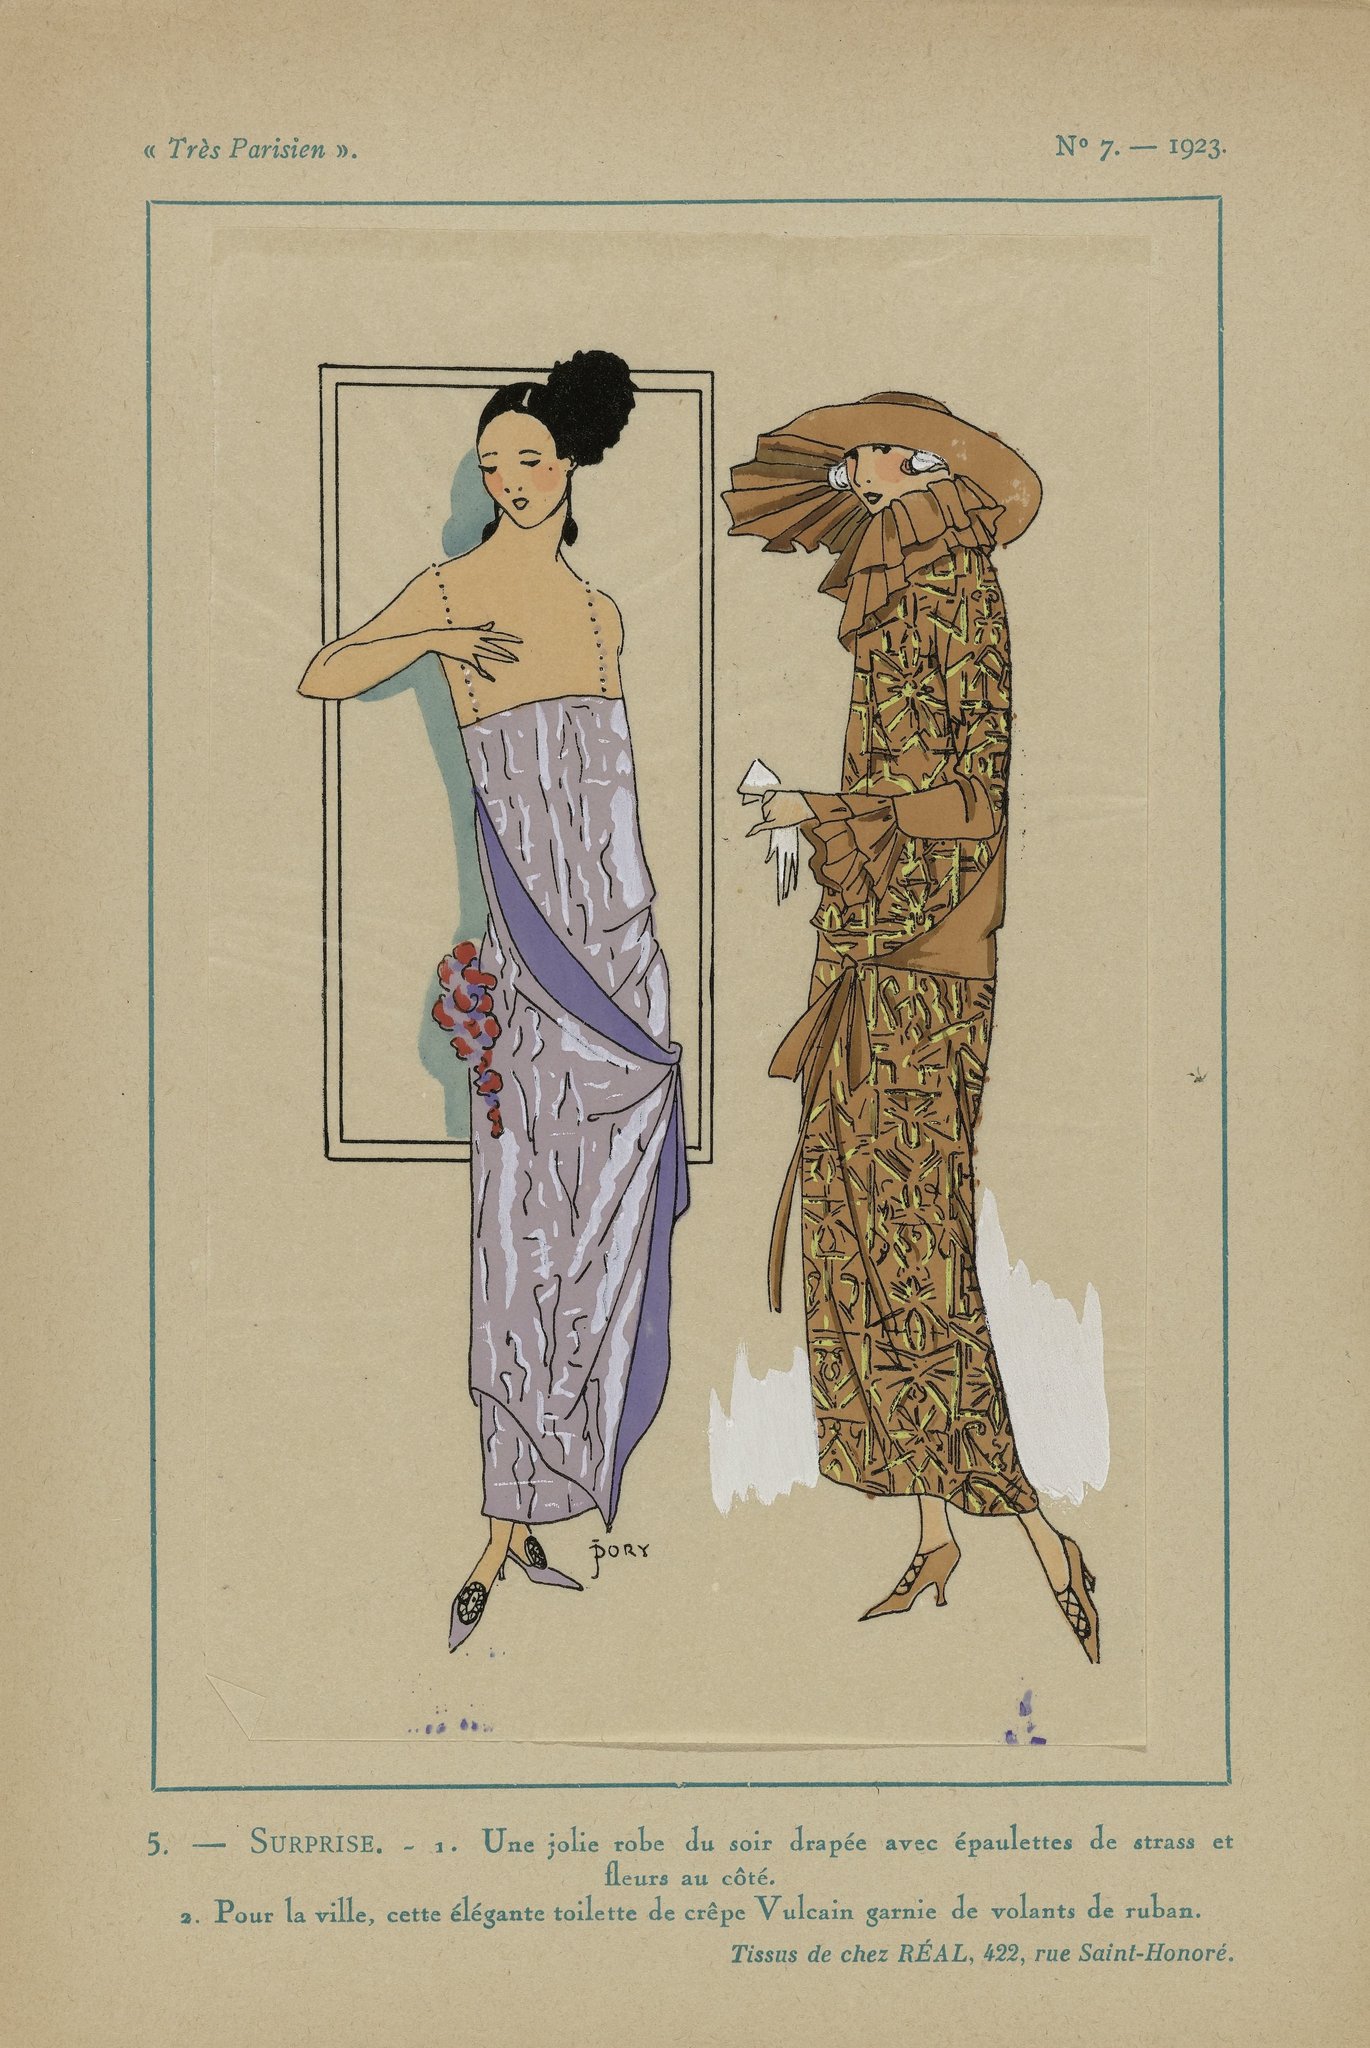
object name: fashion print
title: Très Parisien, 1923, No 7: 5. - SURPRISE. - 1. Une jolie robe du soir...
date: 1923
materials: paper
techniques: hand coloring, letterpress printing, lithography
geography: paris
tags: corsage (+ women's clothes), flowers, dress, gown: evening dress (+ women's clothes), dress, gown: walking dress (+ women's clothes), border, ribbon, braid (+ women's clothes), gloves, mittens (short gloves) (+ women's clothes), fashion plates, head-gear: hat (+ women's clothes)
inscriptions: caption: ‘5. - SURPRISE. - 1. Une jolie robe du soir drapée avec épaulettes de strass et fleurs au côté. 2. Pour la ville,cette élégante toilette de crêpe Vulcain garnie de volants de ruban. / Tissus de chez RÉAL, 422, rue Saint-Honoré.’, title: ‘Très Parisien / No 7. - 1923’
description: 1. Gedrapeerde avondjurk met schouderbanden van strass en bloemcorsage aan één zijde. 2. Voor naar de stad, een 'toilette' van 'crêpe Vulcain' gegarneerd met volants van lint. Accessoires: hoed met brede rand, korte handschoen, schoenen met bandjes en hakken. Stoffen van Réal. Prent uit het modetijdschrift Très Parisien (1920-1936).